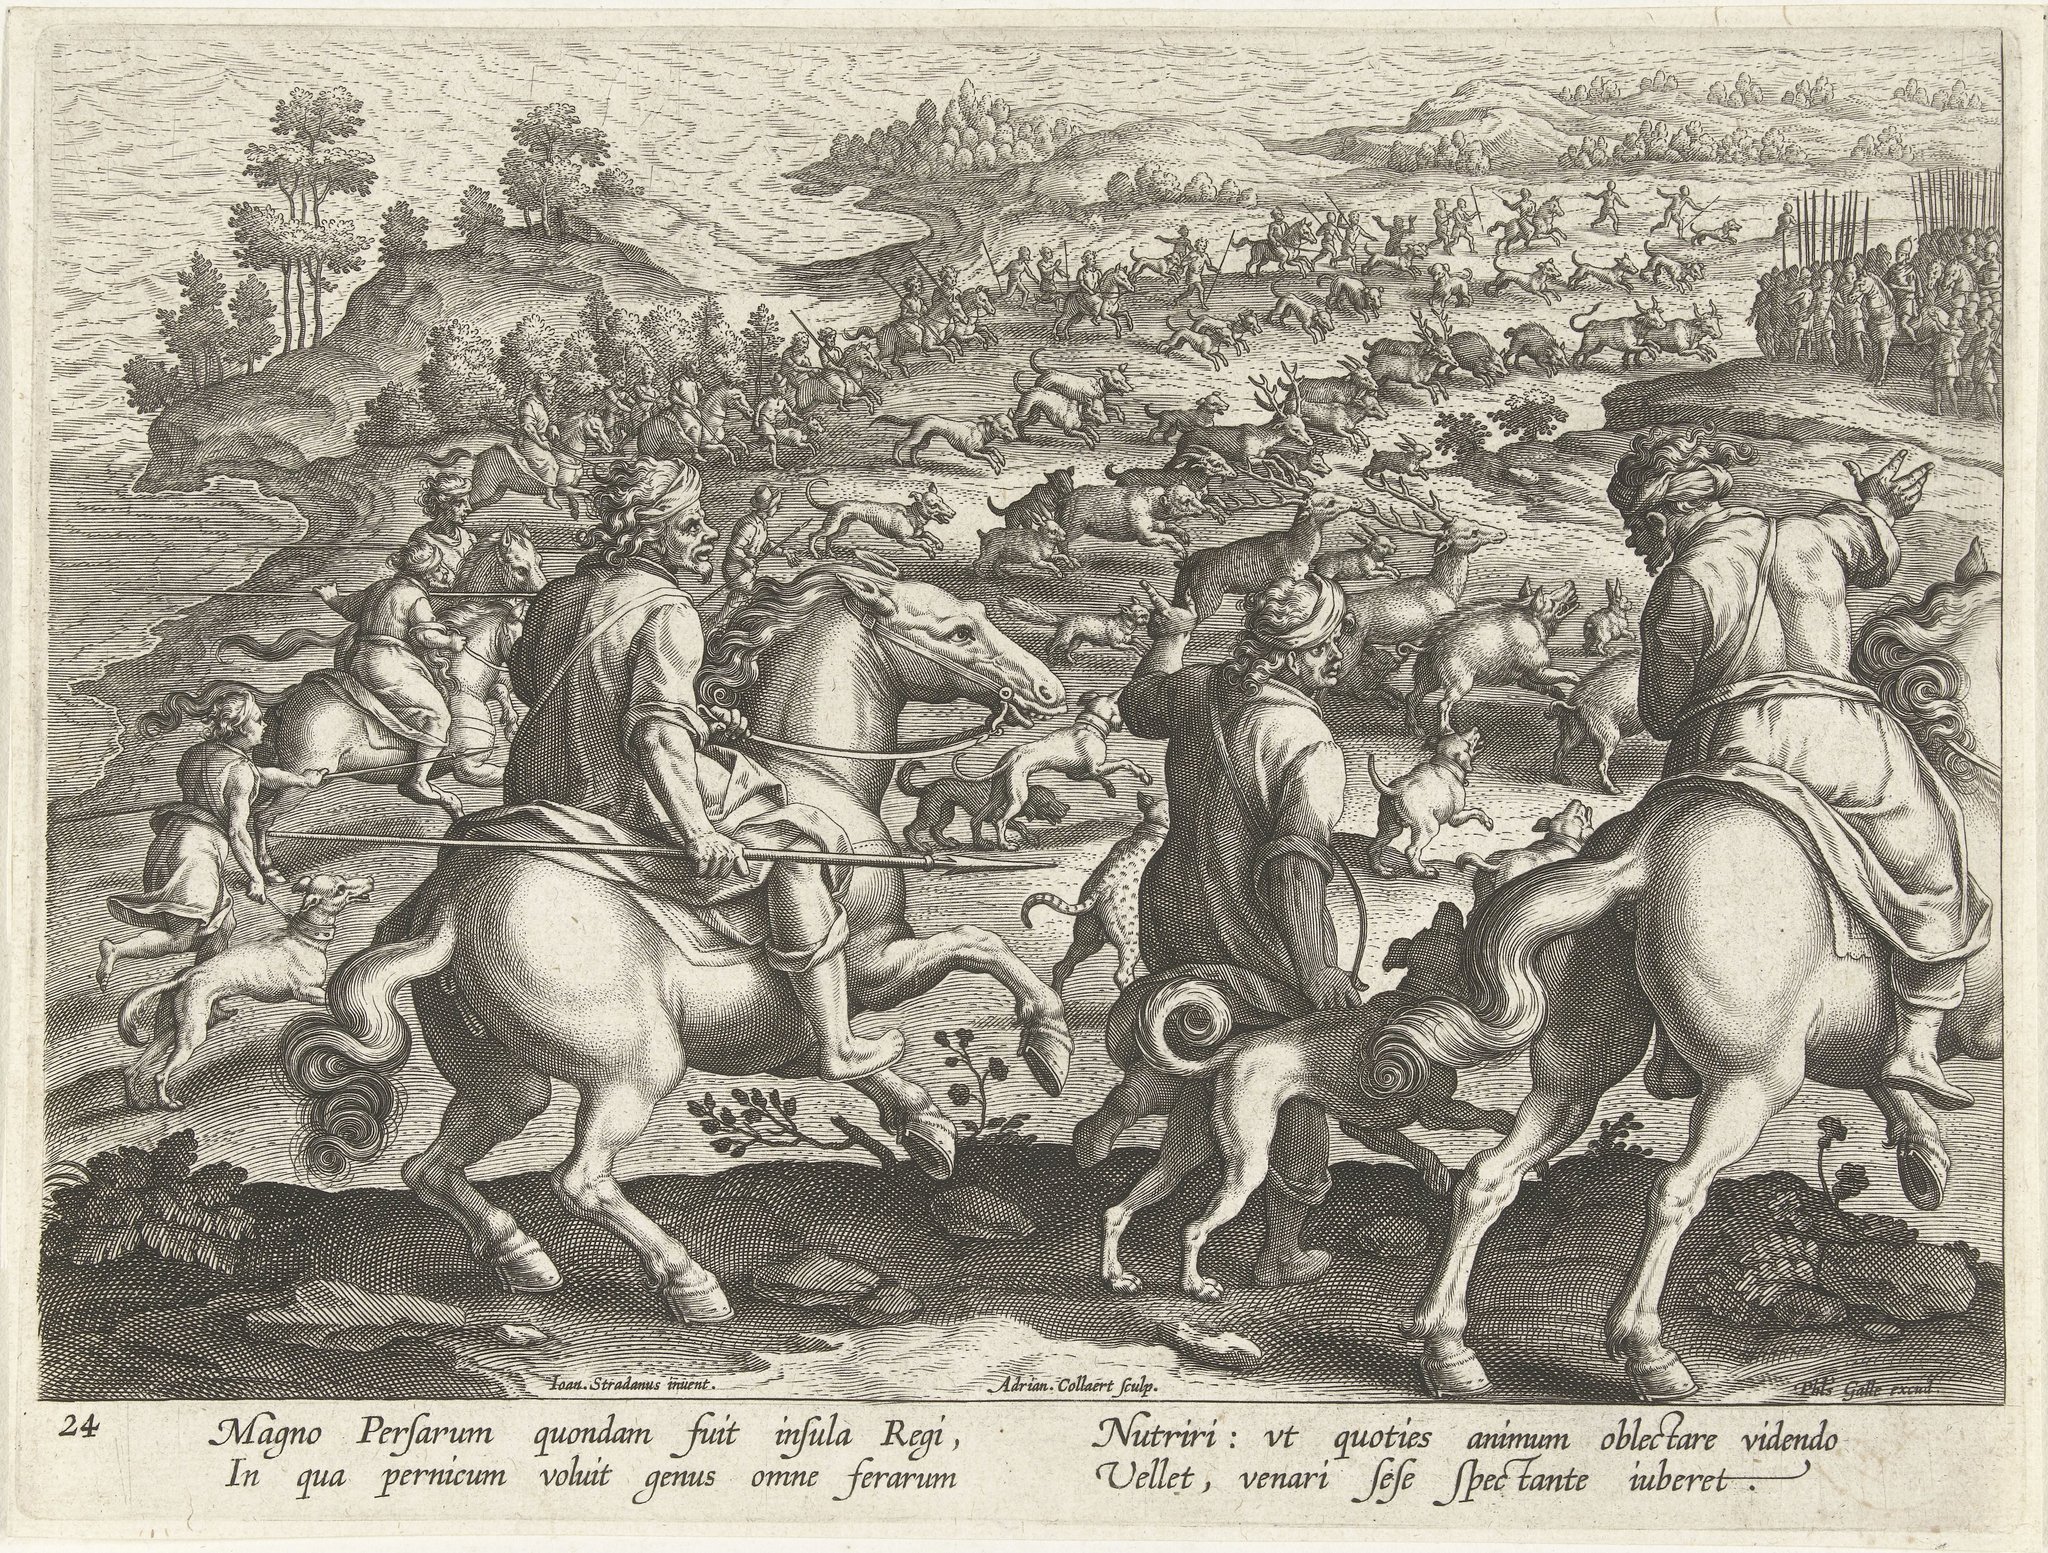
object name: print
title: Venationes Ferarum, auium, piscium pvgnae Bestiariorum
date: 1594-1598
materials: paper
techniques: engraving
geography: antwerp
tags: hunting dogs, hunt ~ mammals, king, hunter (+ hunting with horses), beaters (~ hunt), persia (one of the four world empires)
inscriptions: collector's mark: Lugt 2228, collector's mark: Lugt 240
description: Allerlei wild wordt ruiters opgejaagd richting de koning van Perzië en zijn jagers. Op de voorgrond twee jagers te paard en een hondenafrichter. De prent heeft een Latijns onderschrift en is deel van een serie over jachttaferelen.